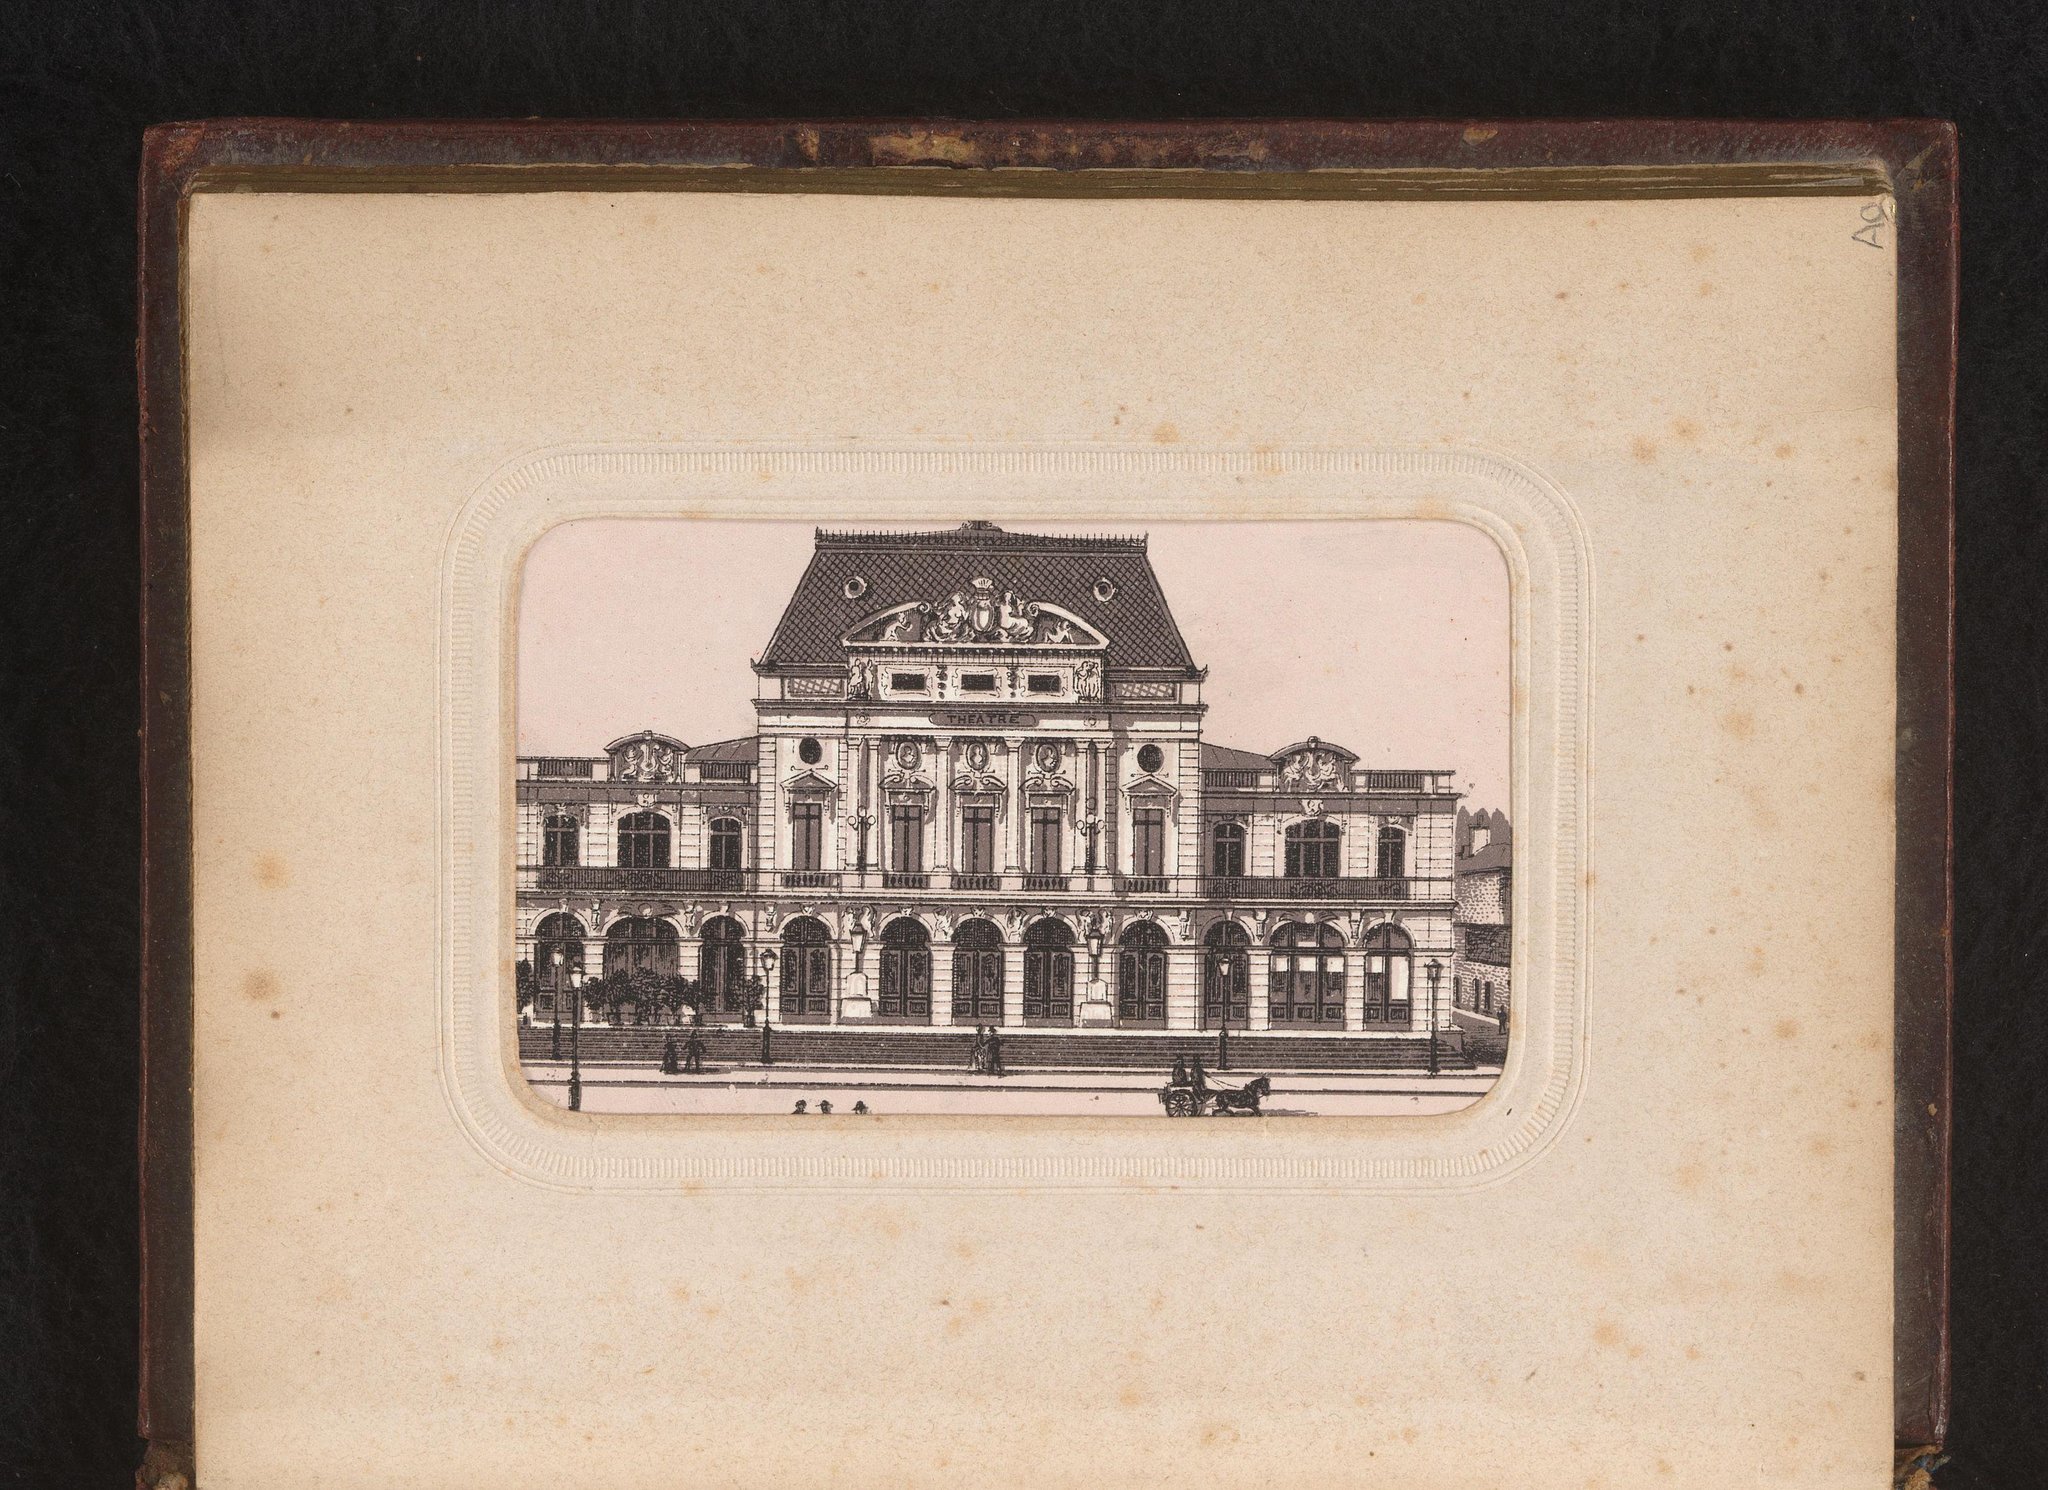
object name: album leaf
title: Gezicht op een theater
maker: Anonymous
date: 1860-1900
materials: cardboard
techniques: lithograph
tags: theatre (building)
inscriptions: inscription: ‘LE THÉATRE’, inscription: ‘ENGLISH SPOKEN’